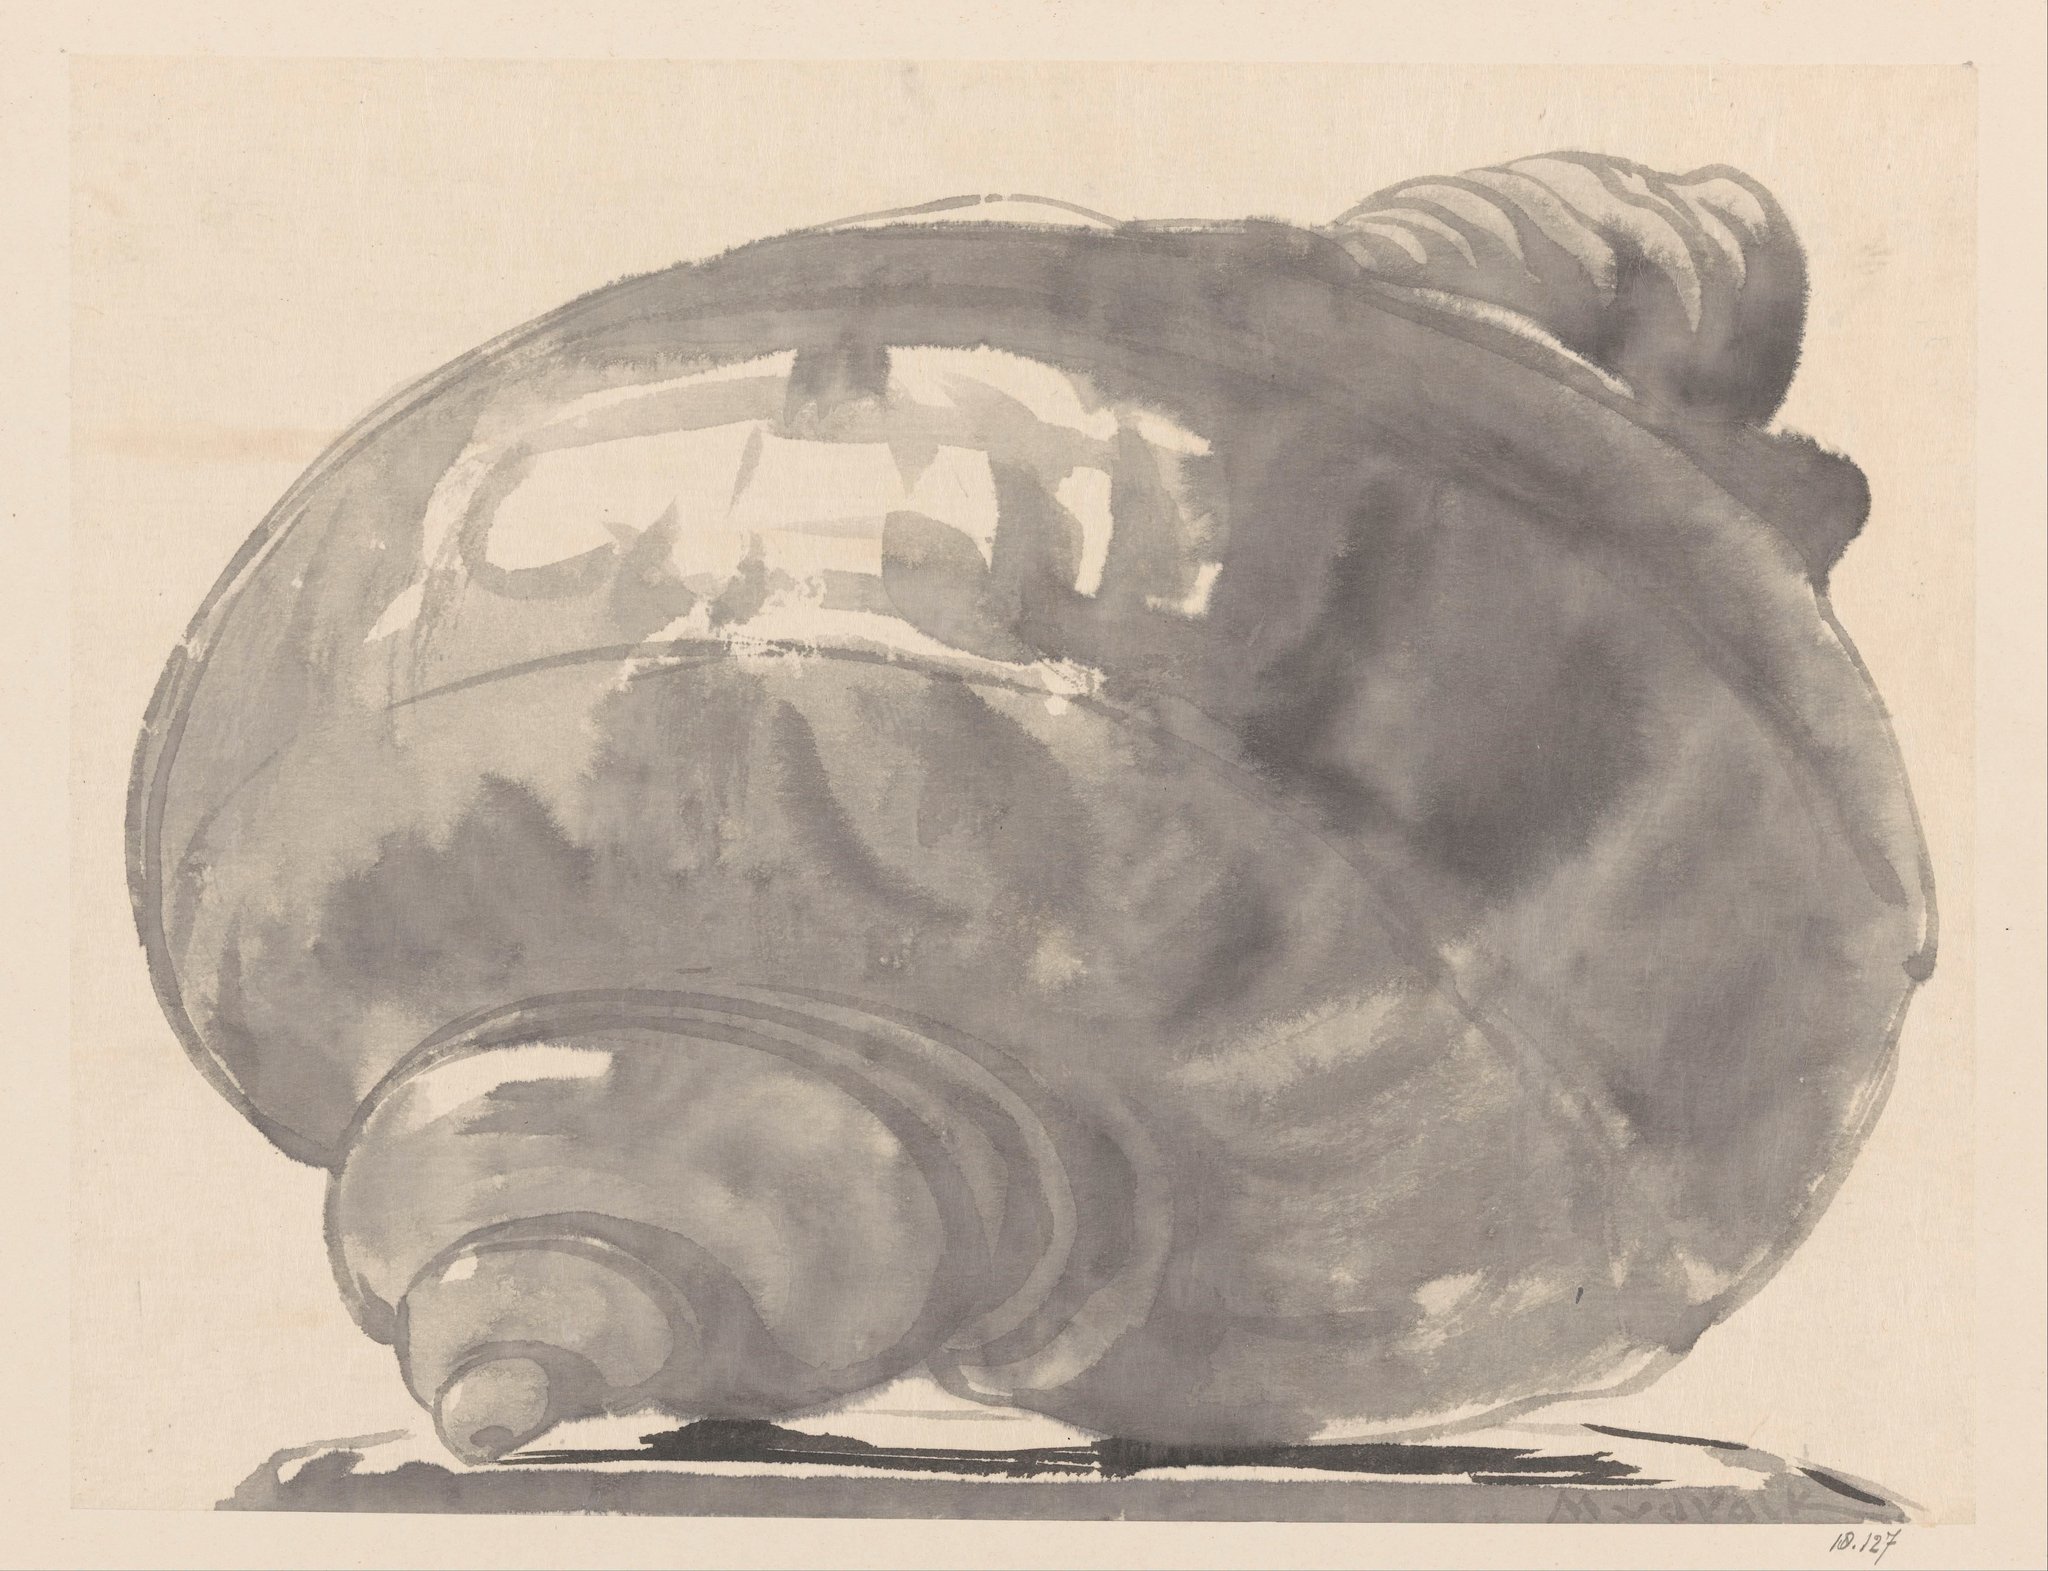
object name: drawing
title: Grote schelp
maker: maurits van der valk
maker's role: draughtsman, print maker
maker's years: 1857-1935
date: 1867-1918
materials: paper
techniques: brush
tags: molluscs (+ shell, snail-shell etc.)